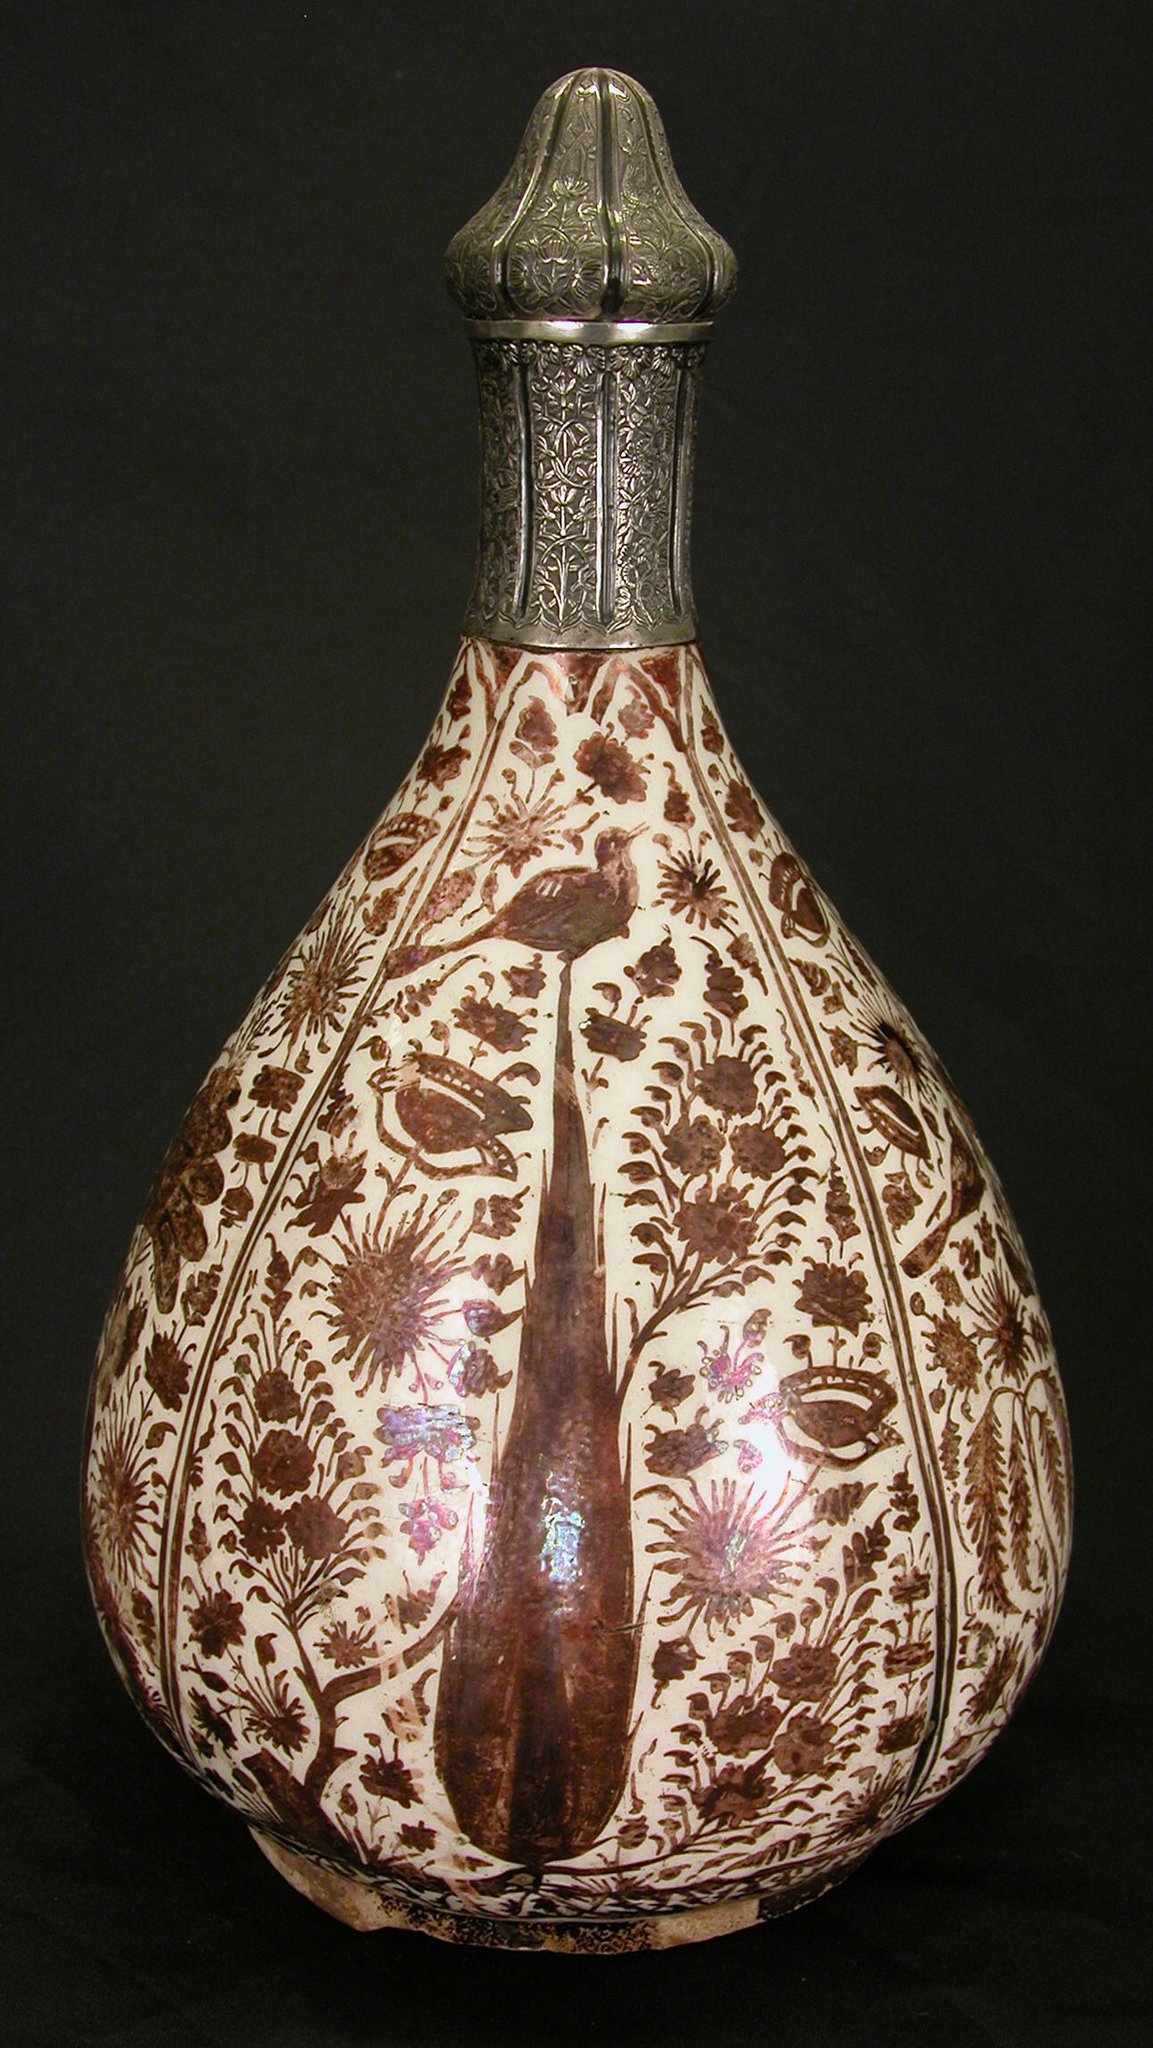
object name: bottle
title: Luster-Painted Bottle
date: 1651-1700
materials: glaze, silver, stonepaste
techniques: luster painting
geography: iran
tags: birds,flowers,cypresses